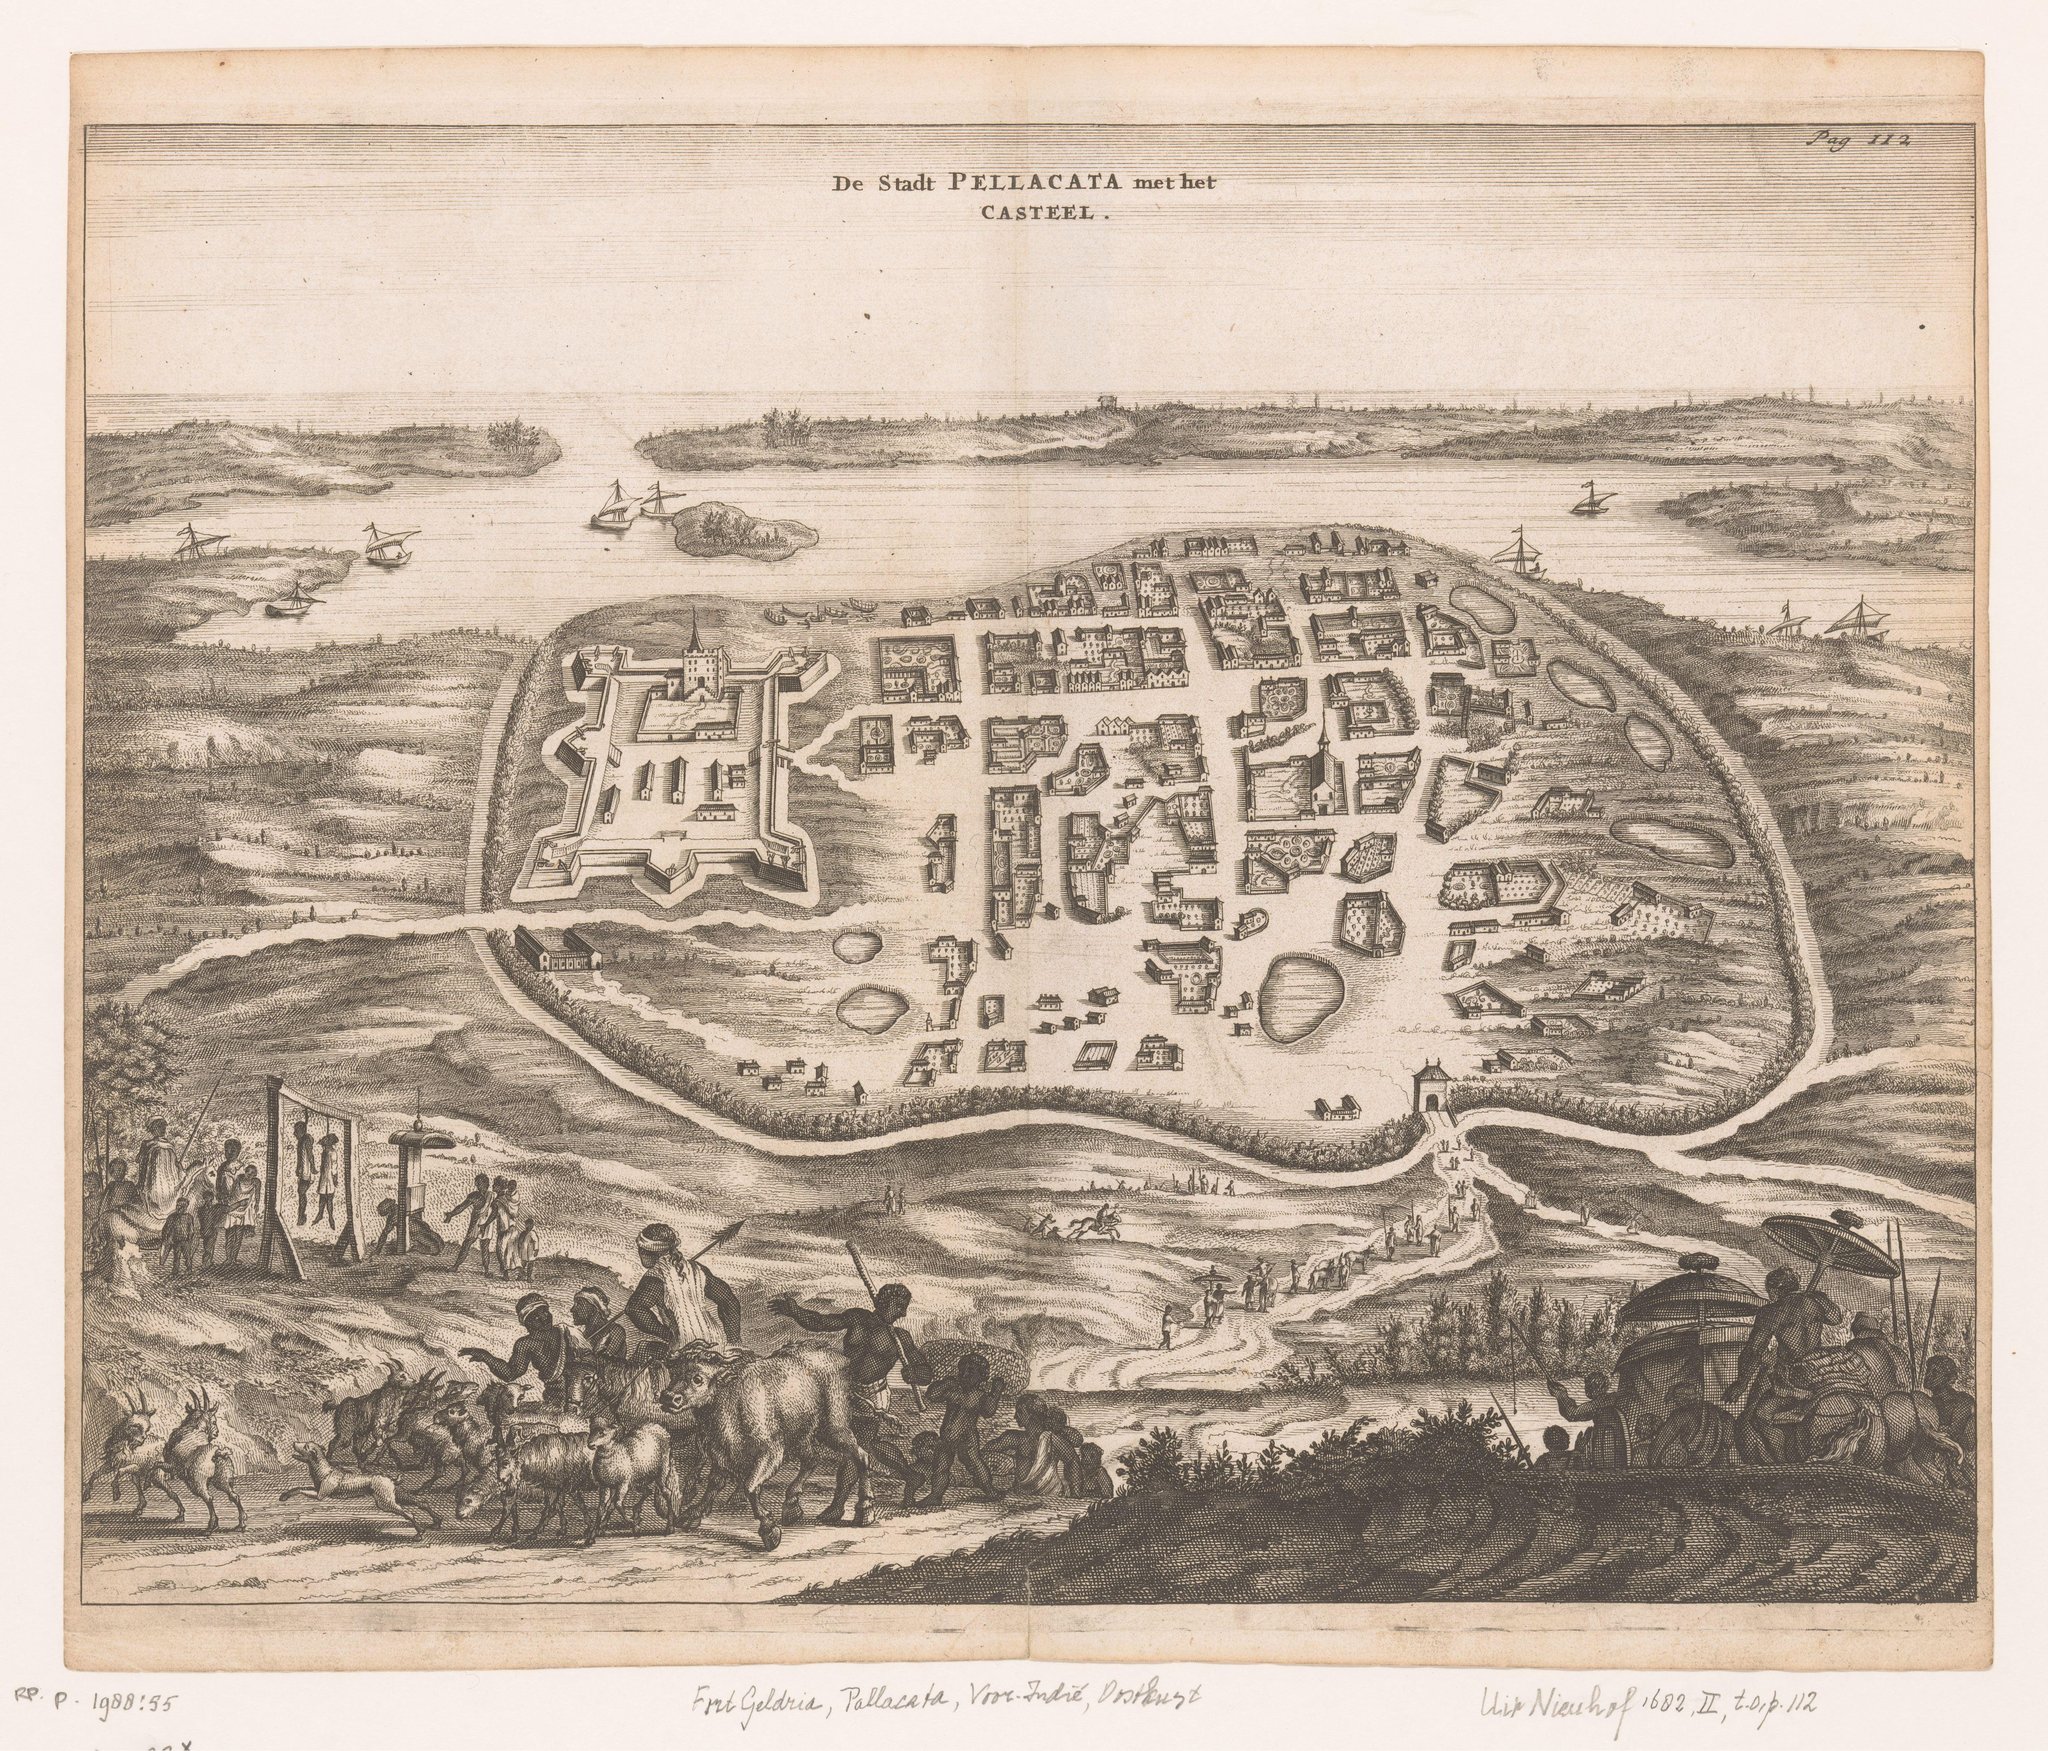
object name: print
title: Vogelvluchtperspectief van Pulicat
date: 1682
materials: paper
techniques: engraving, etching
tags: body of the executed displayed in public, maps of cities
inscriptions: collector's mark: Lugt 2760, collector's mark: Lugt 2228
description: Vogelvluchtperspectief van de stad Pulicat, met rechts van het midden Fort Geldria. In het landschap op de voorgrond reizigers, herders met een kudde en een galg met twee gehangenen.